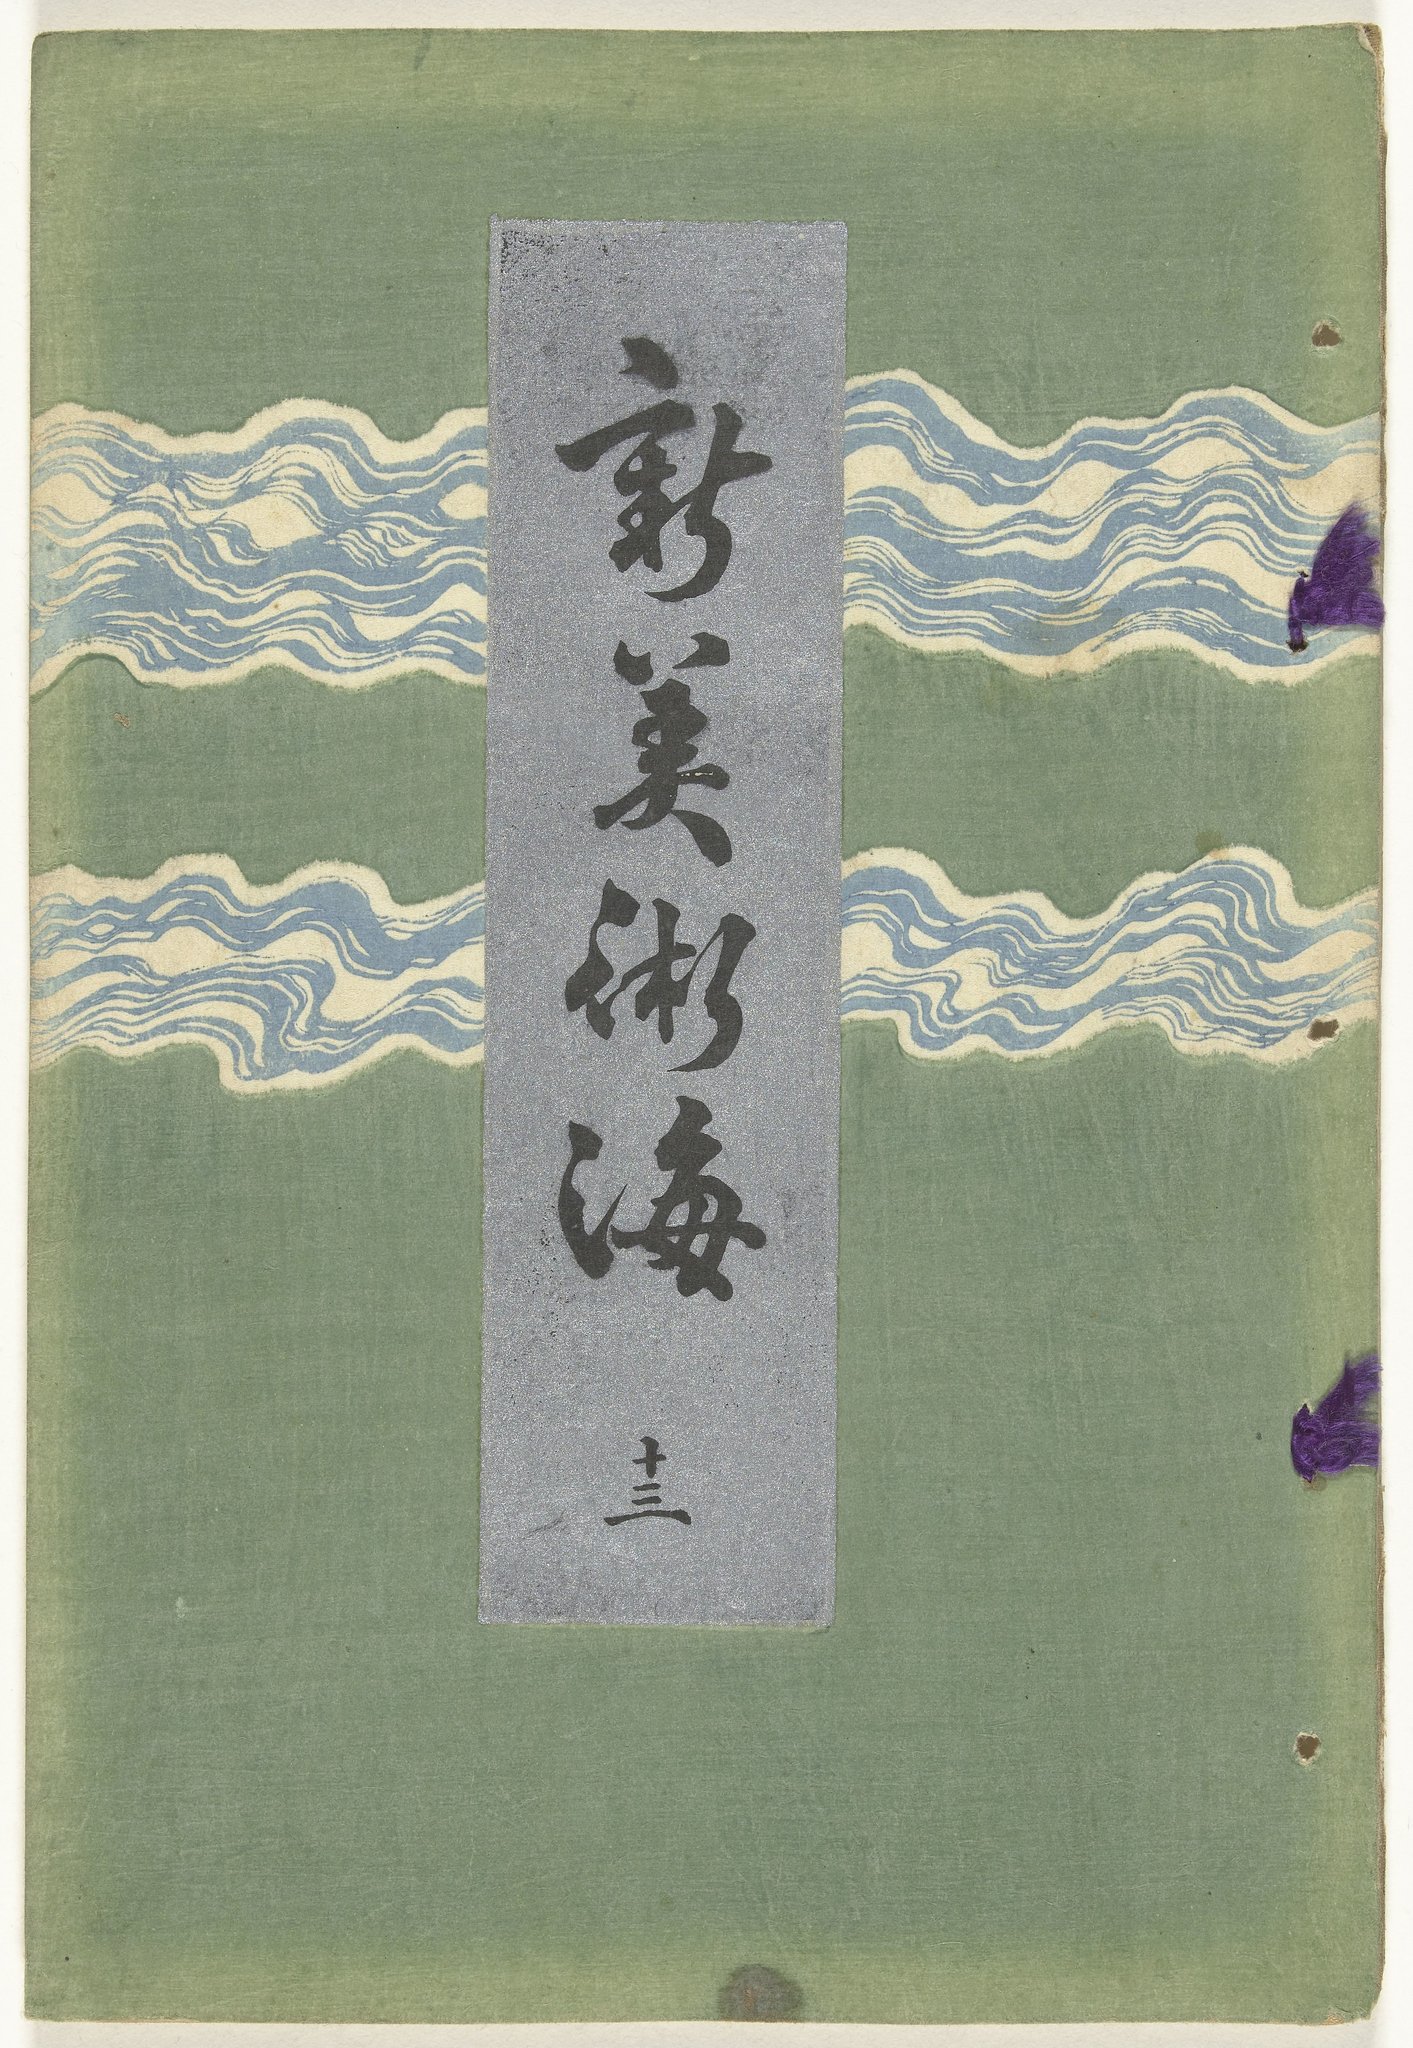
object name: book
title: Nieuwe zee der kunsten - 13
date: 1903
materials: paper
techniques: woodcut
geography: kyoto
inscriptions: date